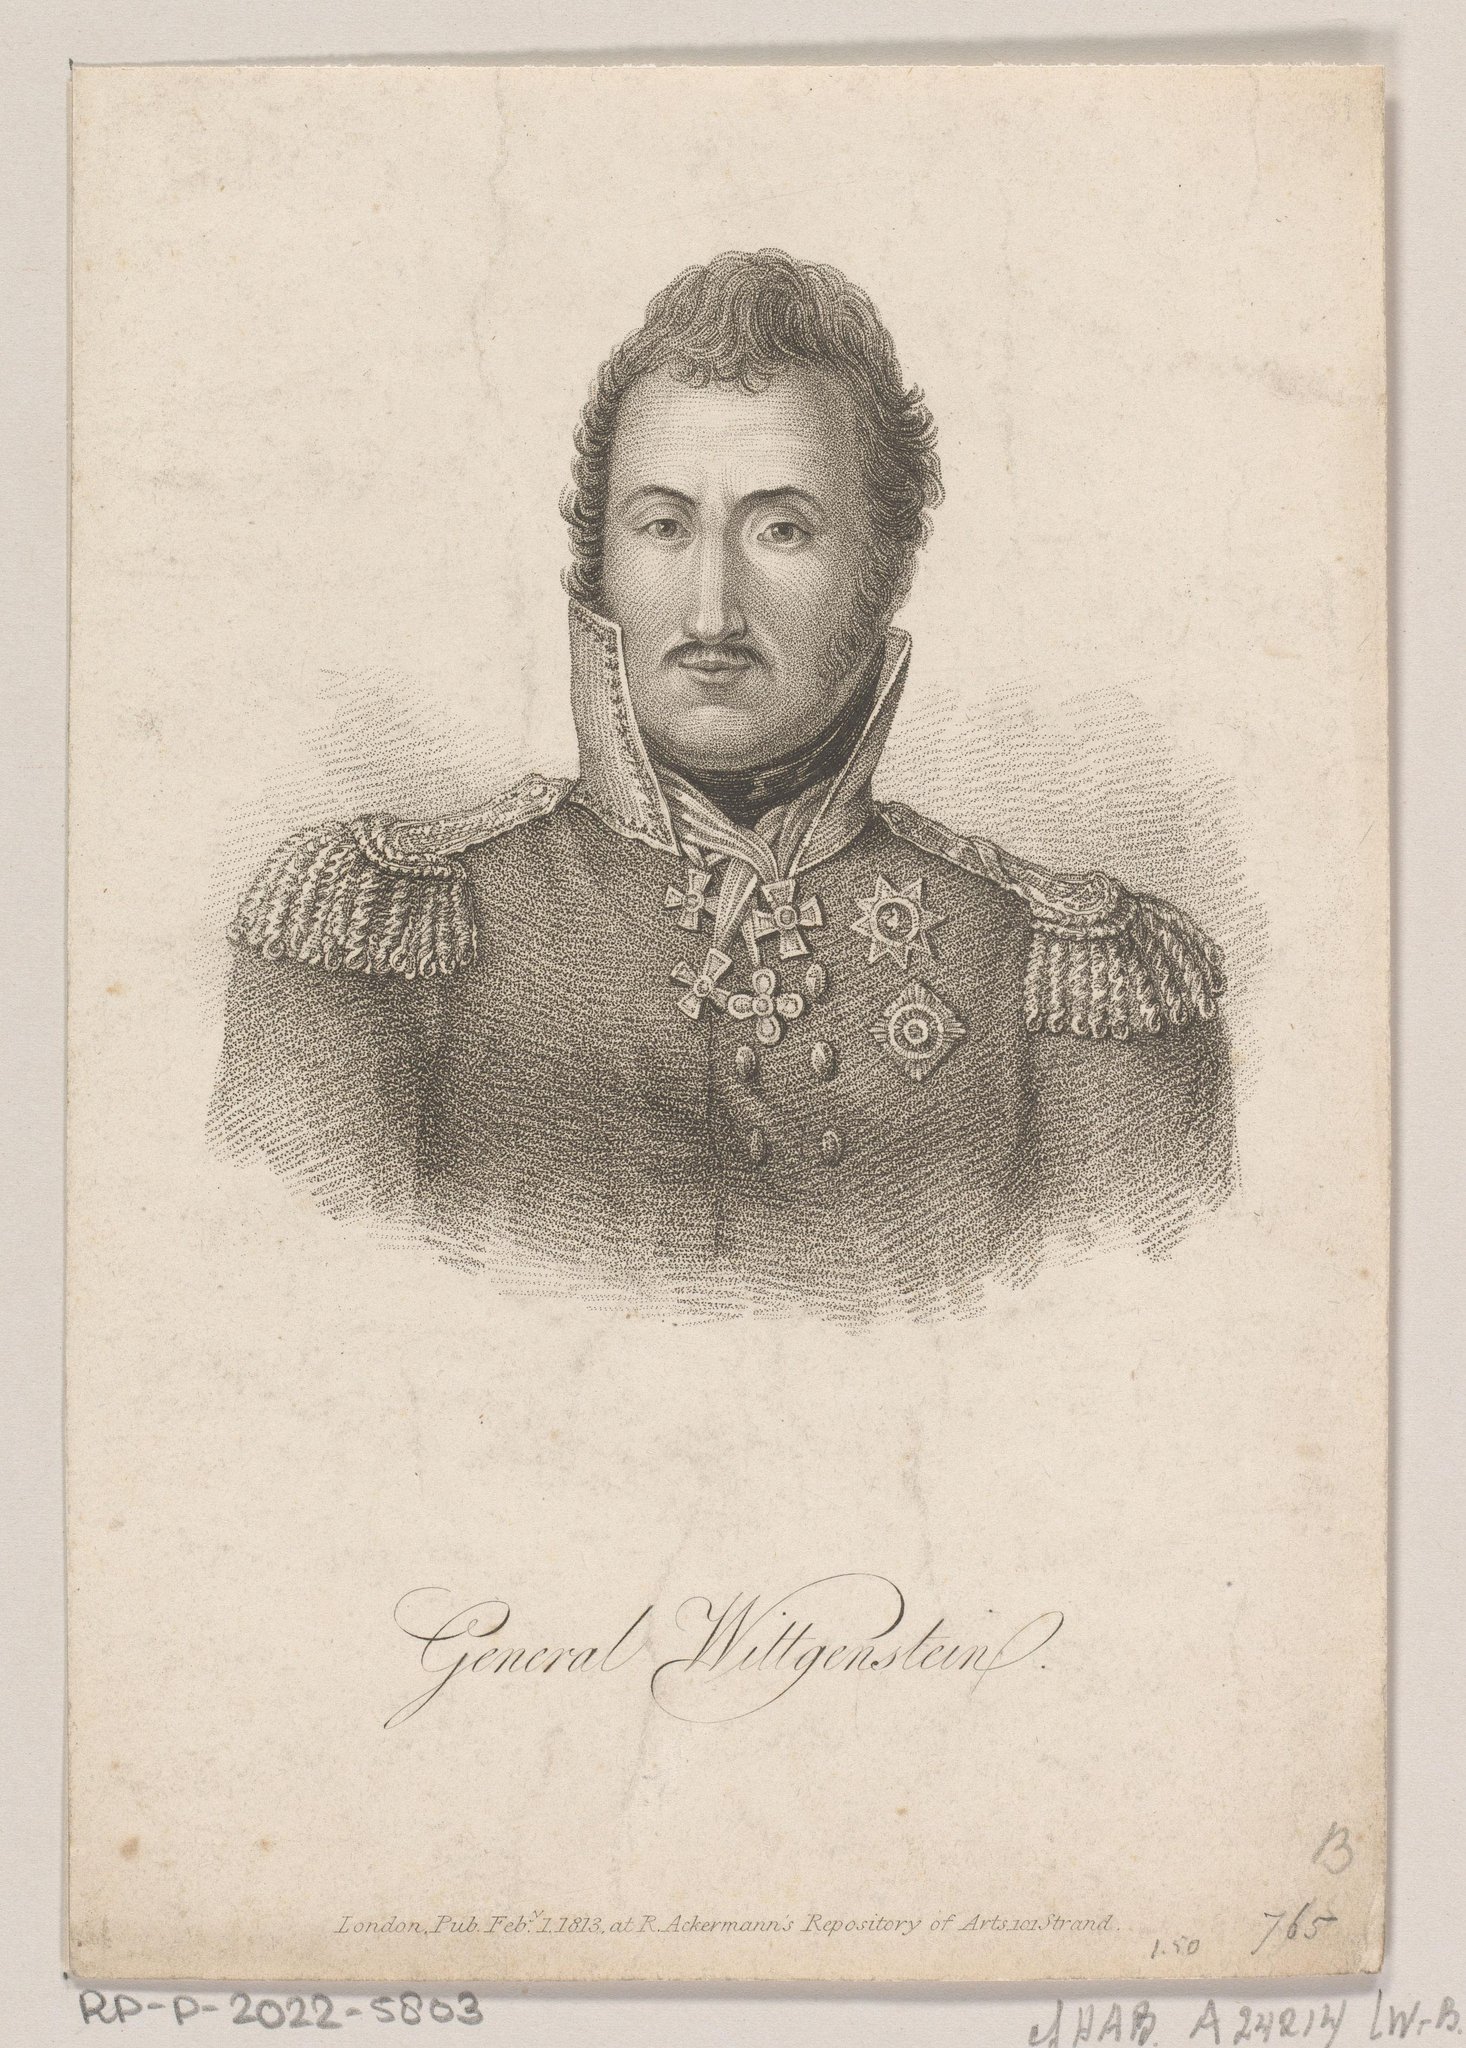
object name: print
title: Portret van Ludwig Adolph Peter Fürst von Sayn-Wittgenstein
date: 1813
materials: paper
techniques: etching, roulette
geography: london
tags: knighthood order, historical persons, (military) uniforms